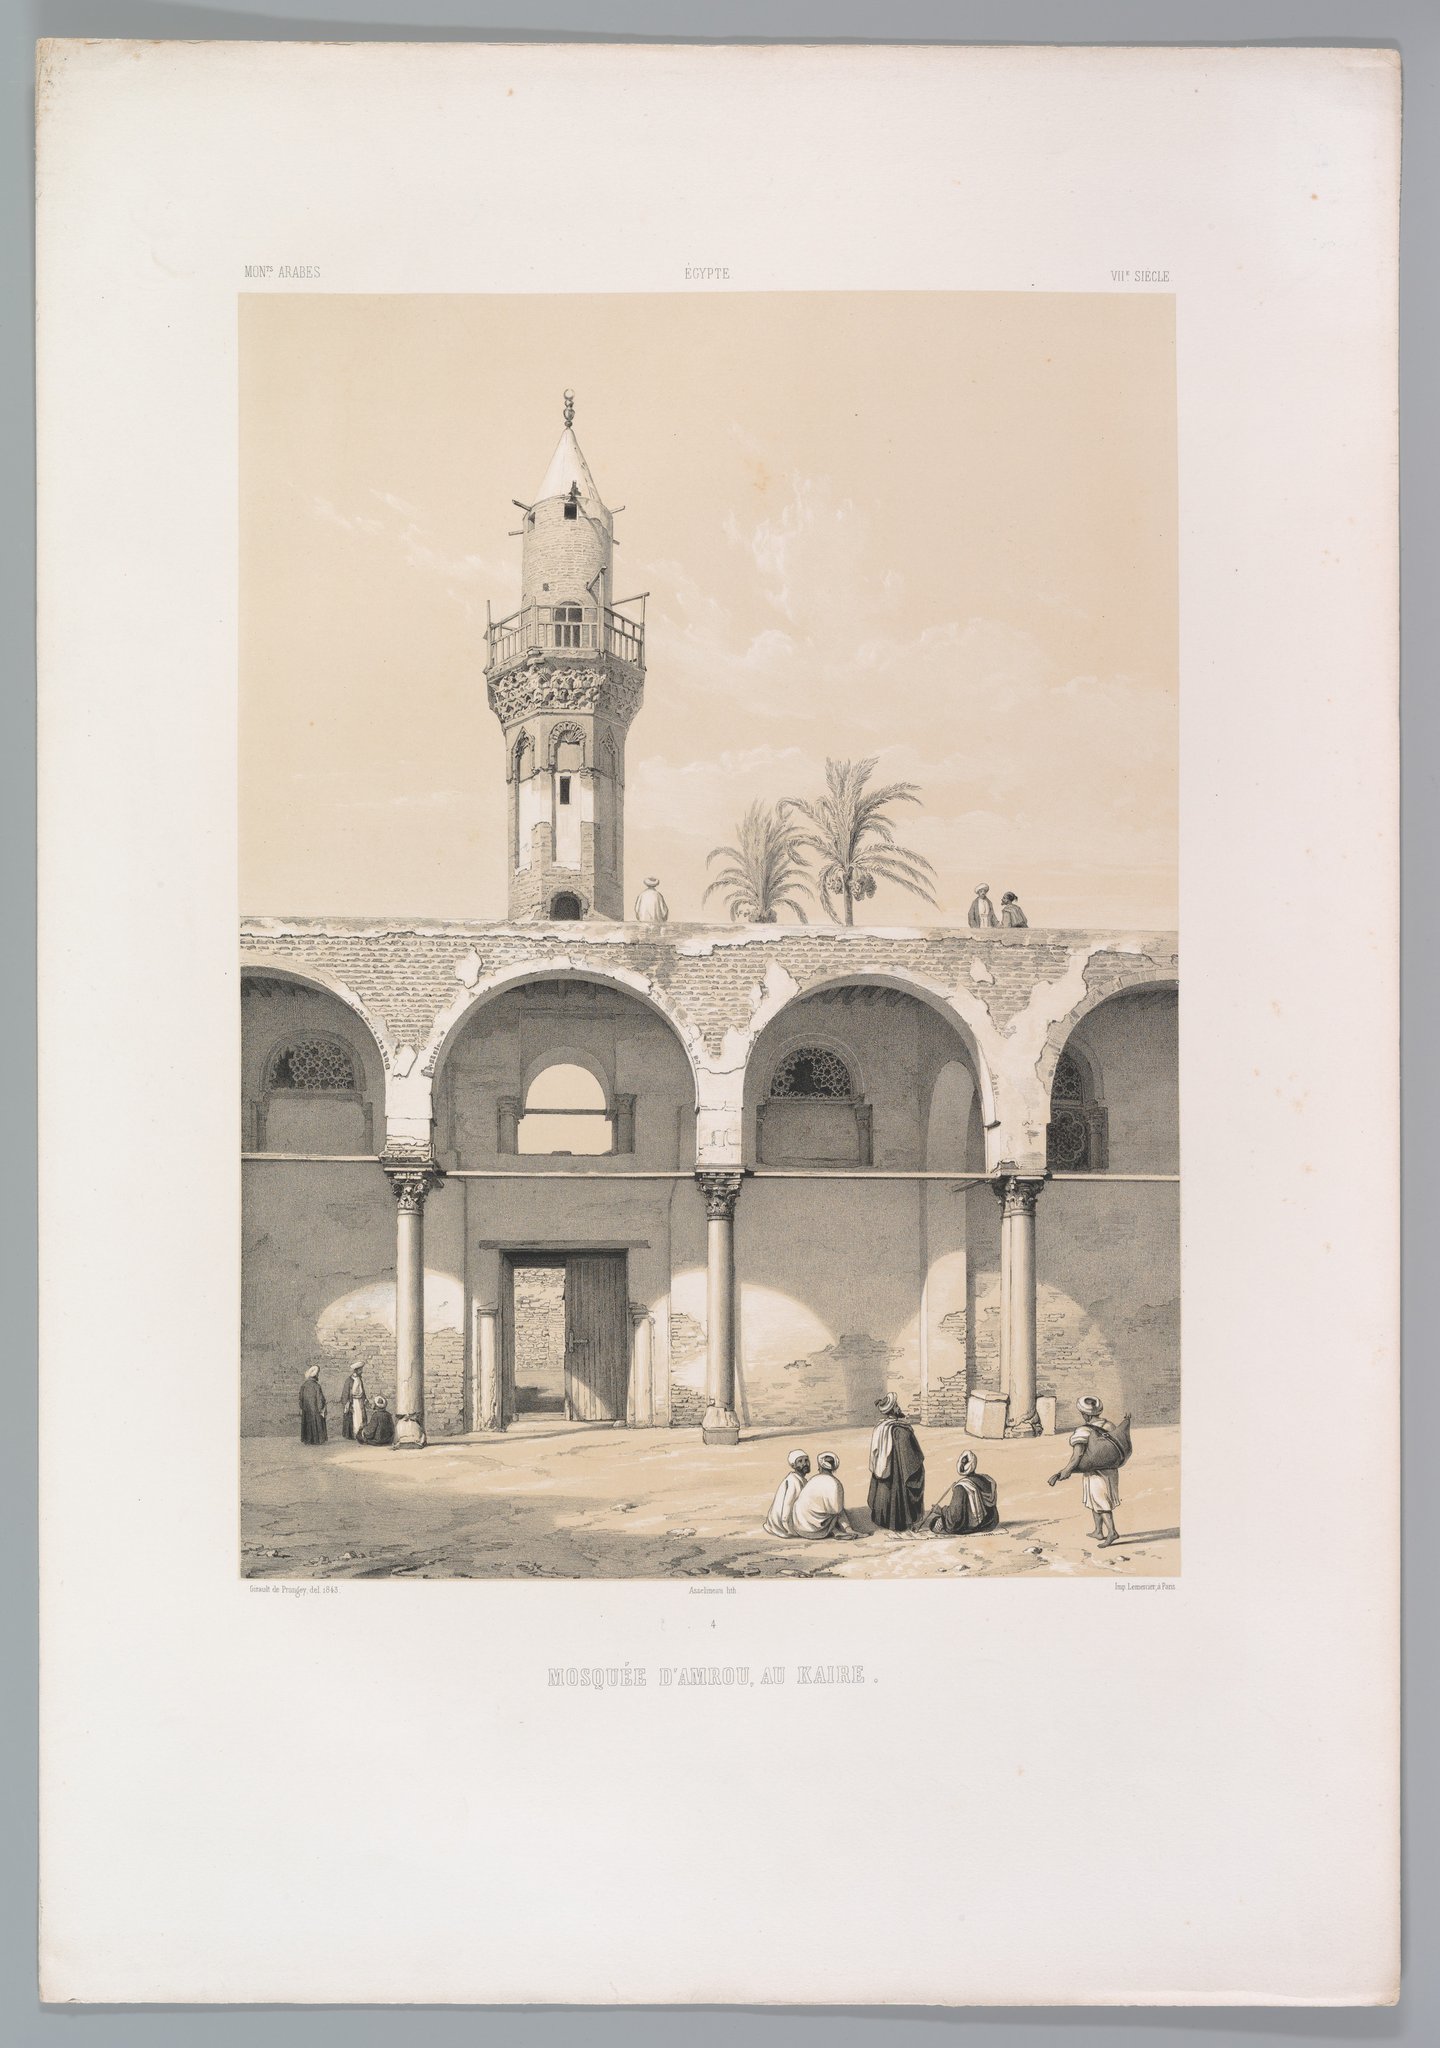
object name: lithograph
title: 4. Mosquée d’Amrou, au Kaire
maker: joseph-philibert girault de prangey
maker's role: artist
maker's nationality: french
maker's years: 1804-1892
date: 1843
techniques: lithograph